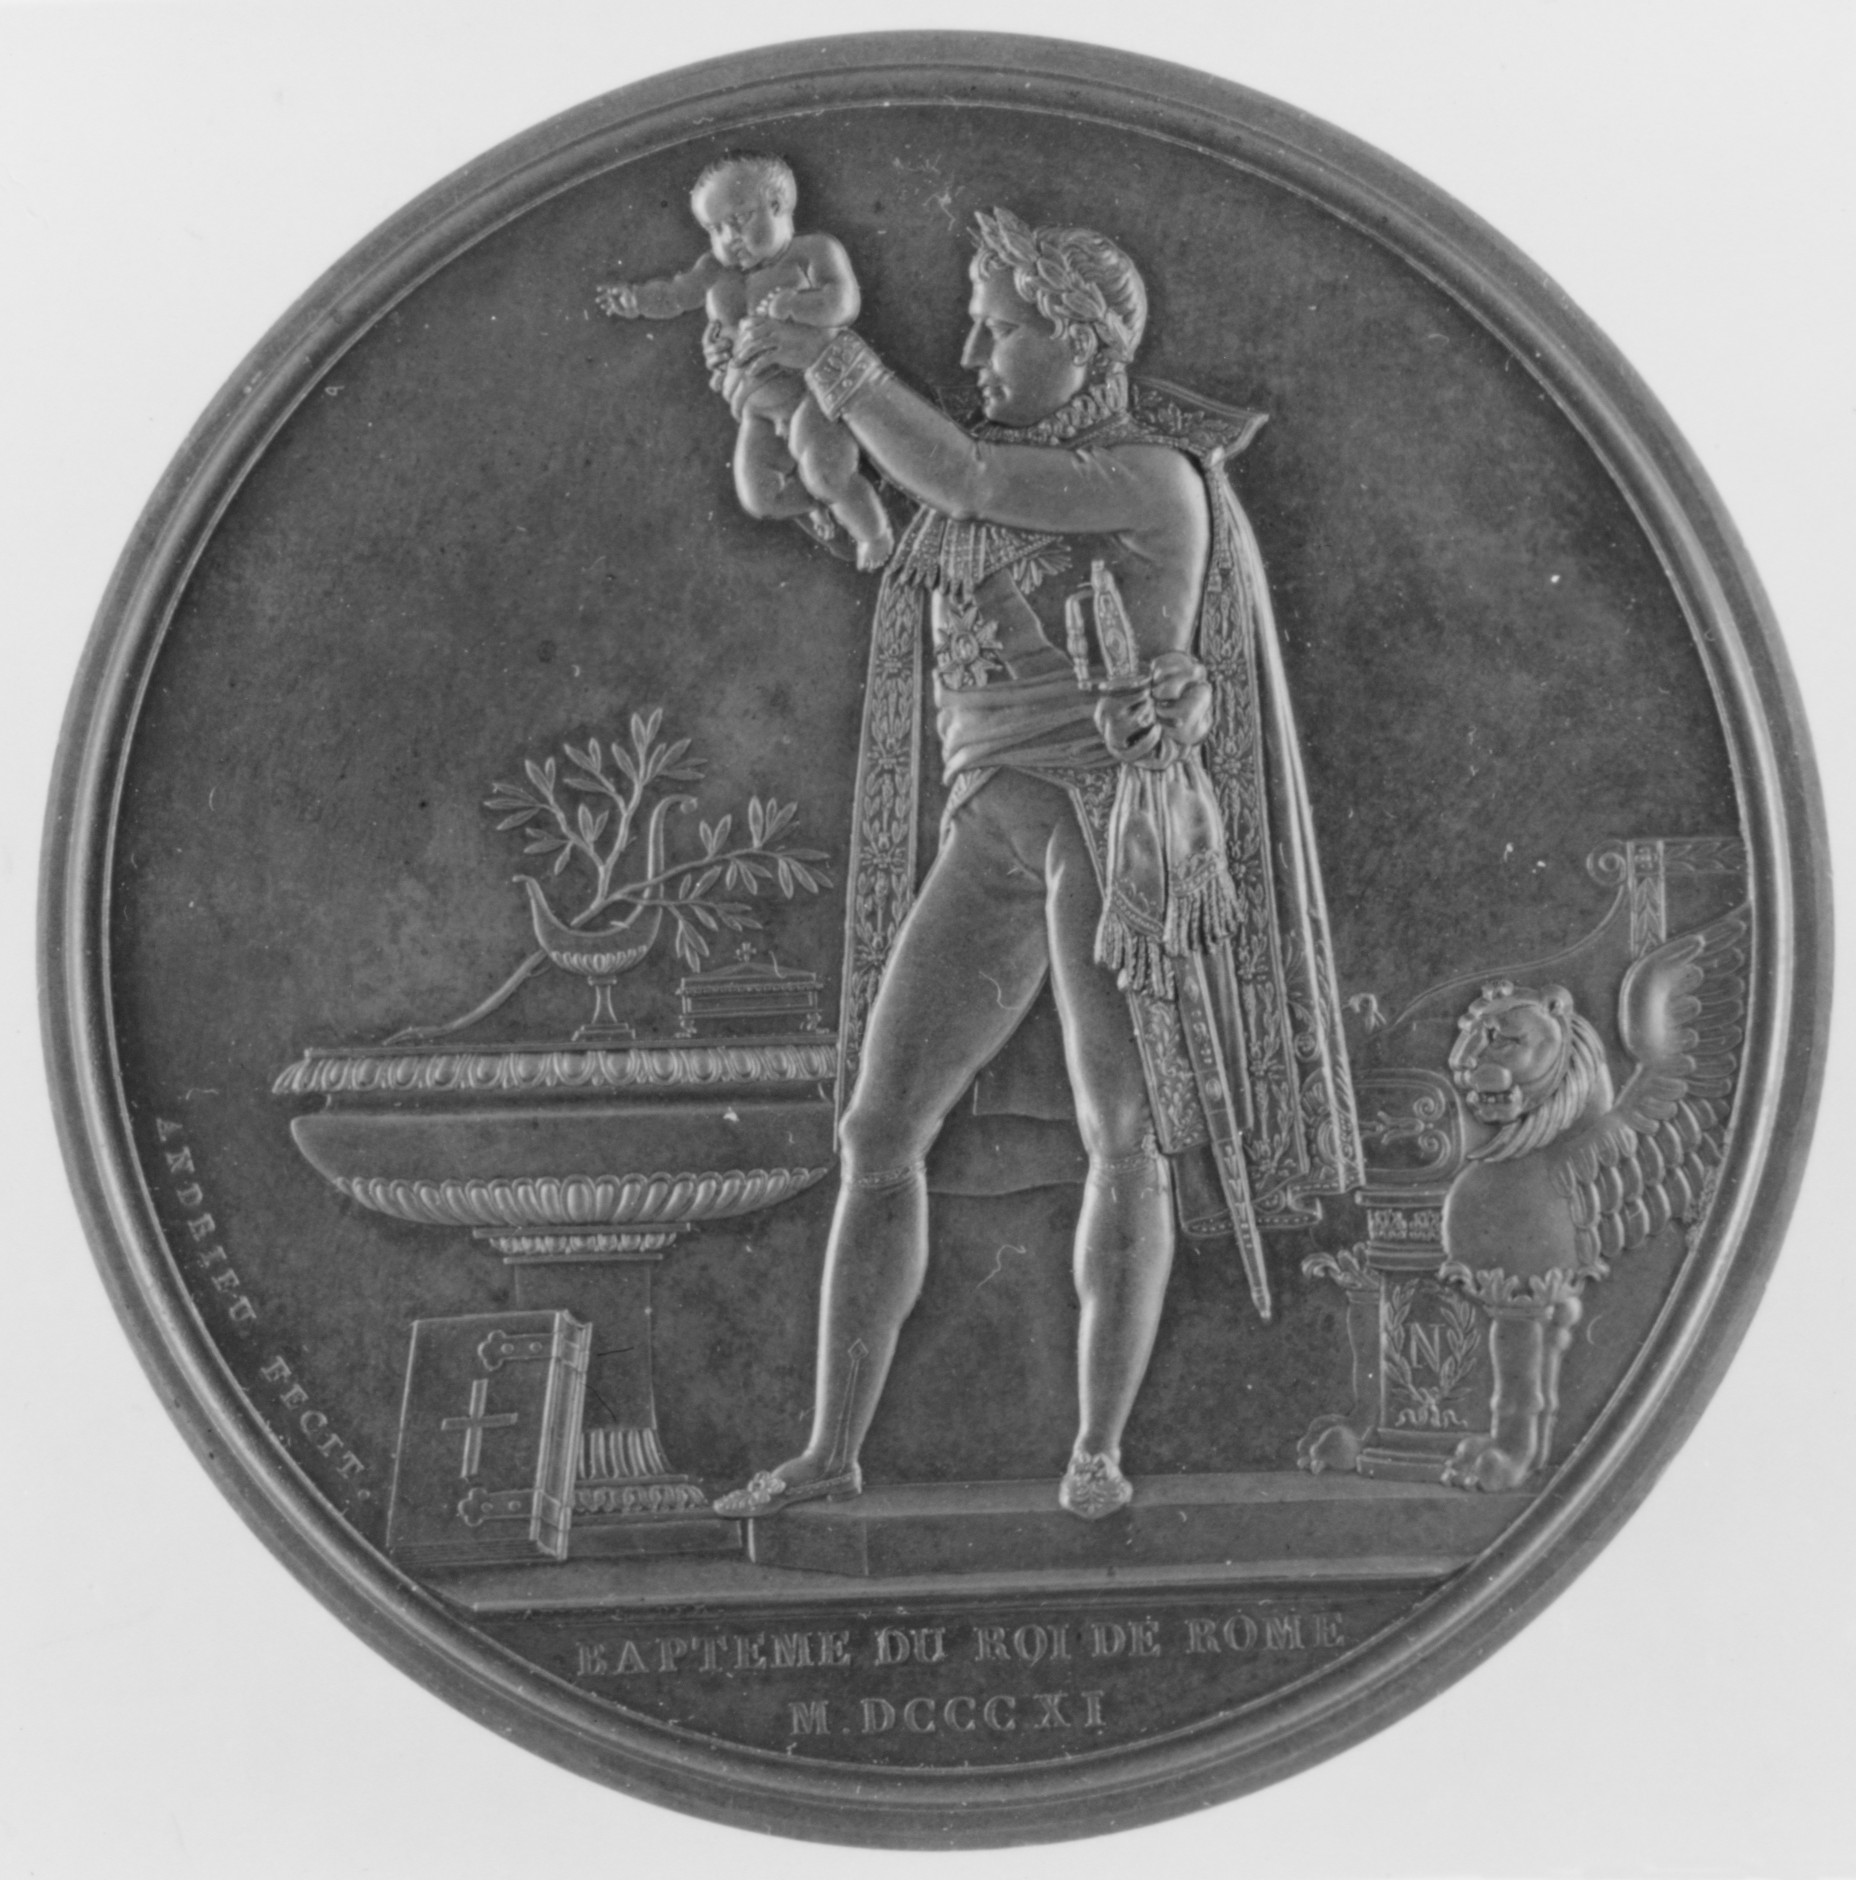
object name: medal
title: Baptism of King of Rome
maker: bertrand andrieu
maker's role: artist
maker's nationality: french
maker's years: 1761-1822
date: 1811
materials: gilt bronze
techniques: struck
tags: infants,men